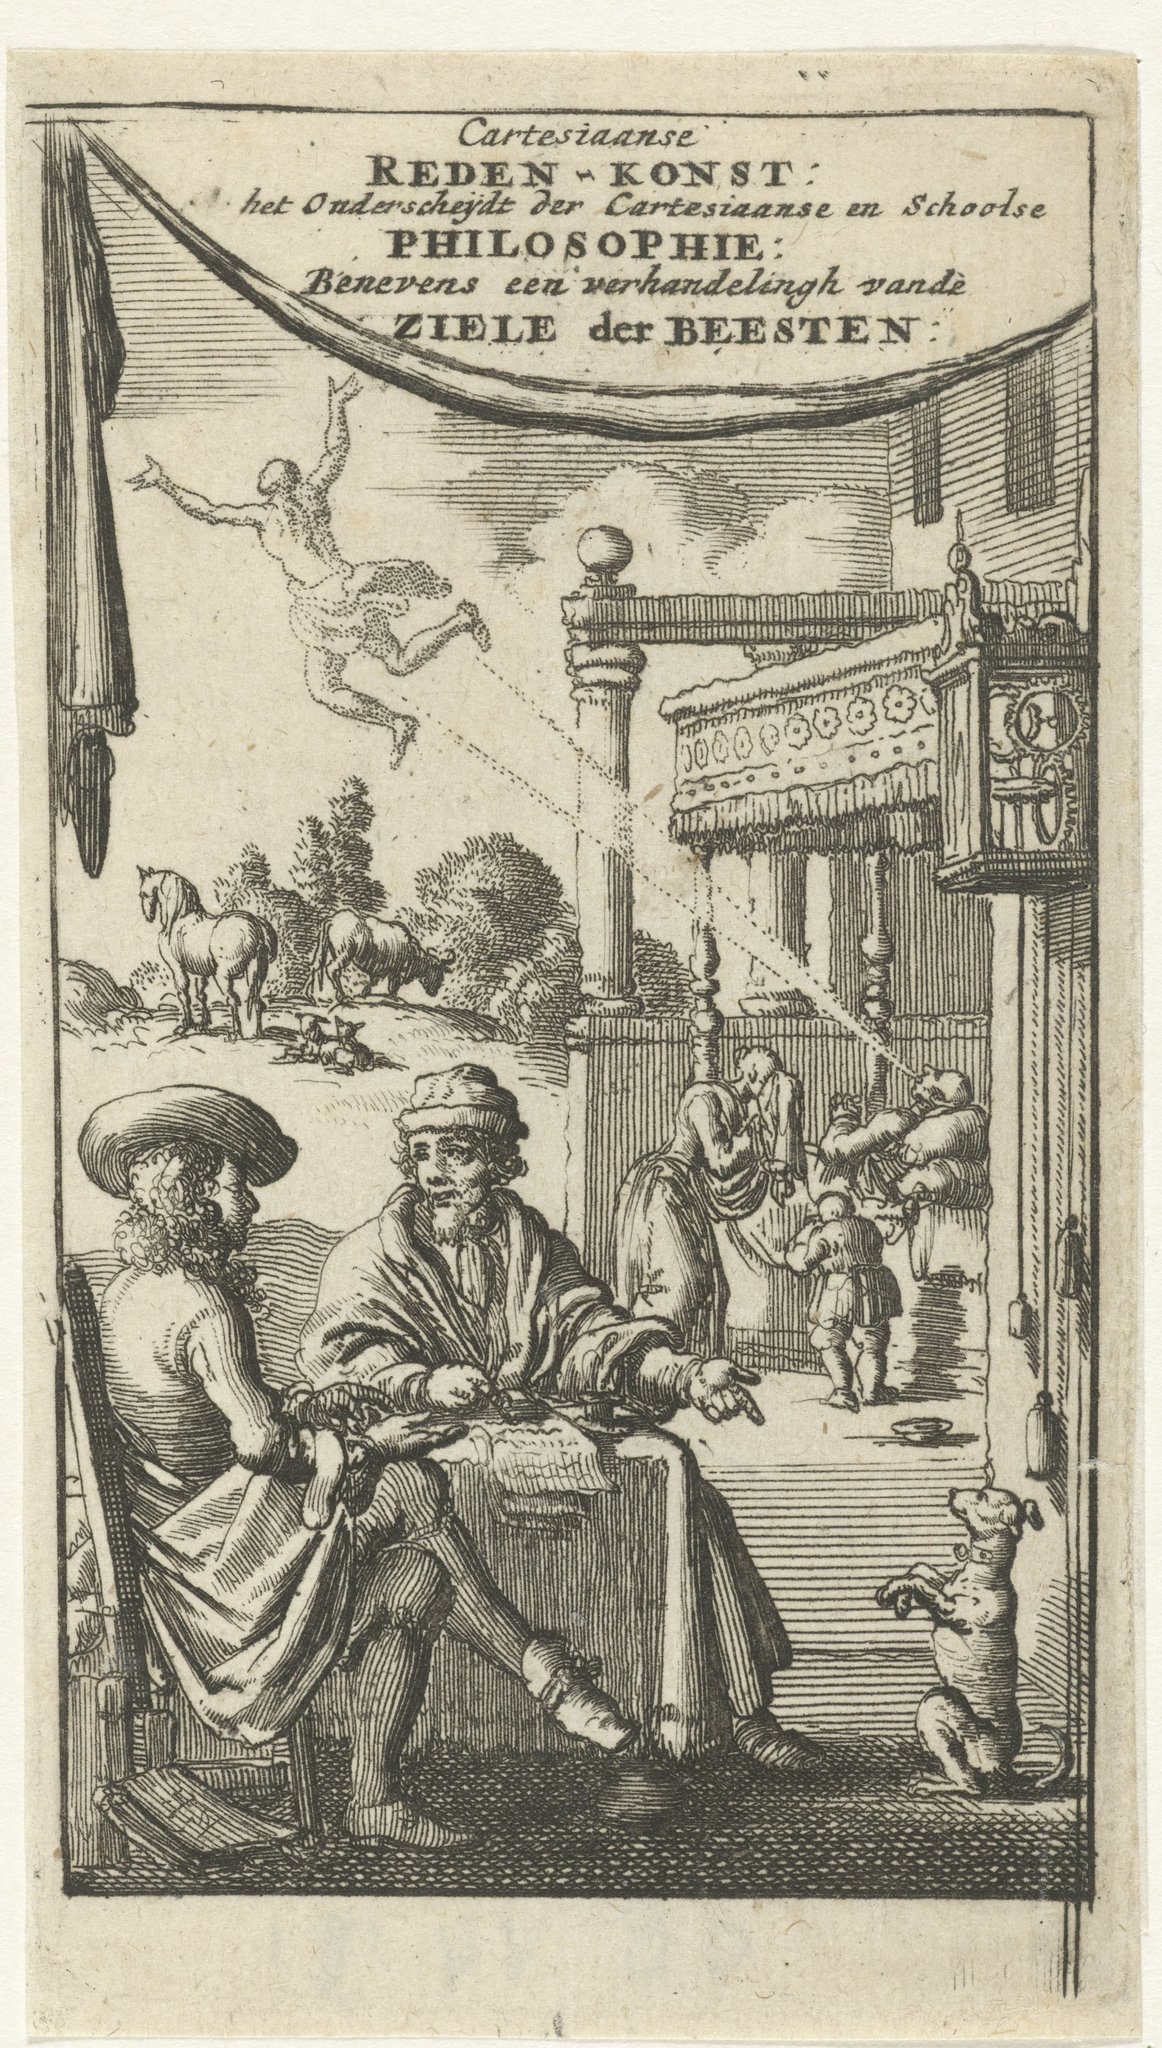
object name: print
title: Titelpagina voor: J. du Roure, Cartesiaanse reden-konst, 1683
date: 1683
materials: paper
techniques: etching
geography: amsterdam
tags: deathbed, training of dogs, the soul going to its last destination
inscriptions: collector's mark: Lugt 2228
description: Een jonge en oude man zitten aan tafel en aanschouwen een opzittend hondje. Hierachter huilen een vrouw en kind bij het sterfbed van een man die zijn laatste adem (en ziel) uitblaast.